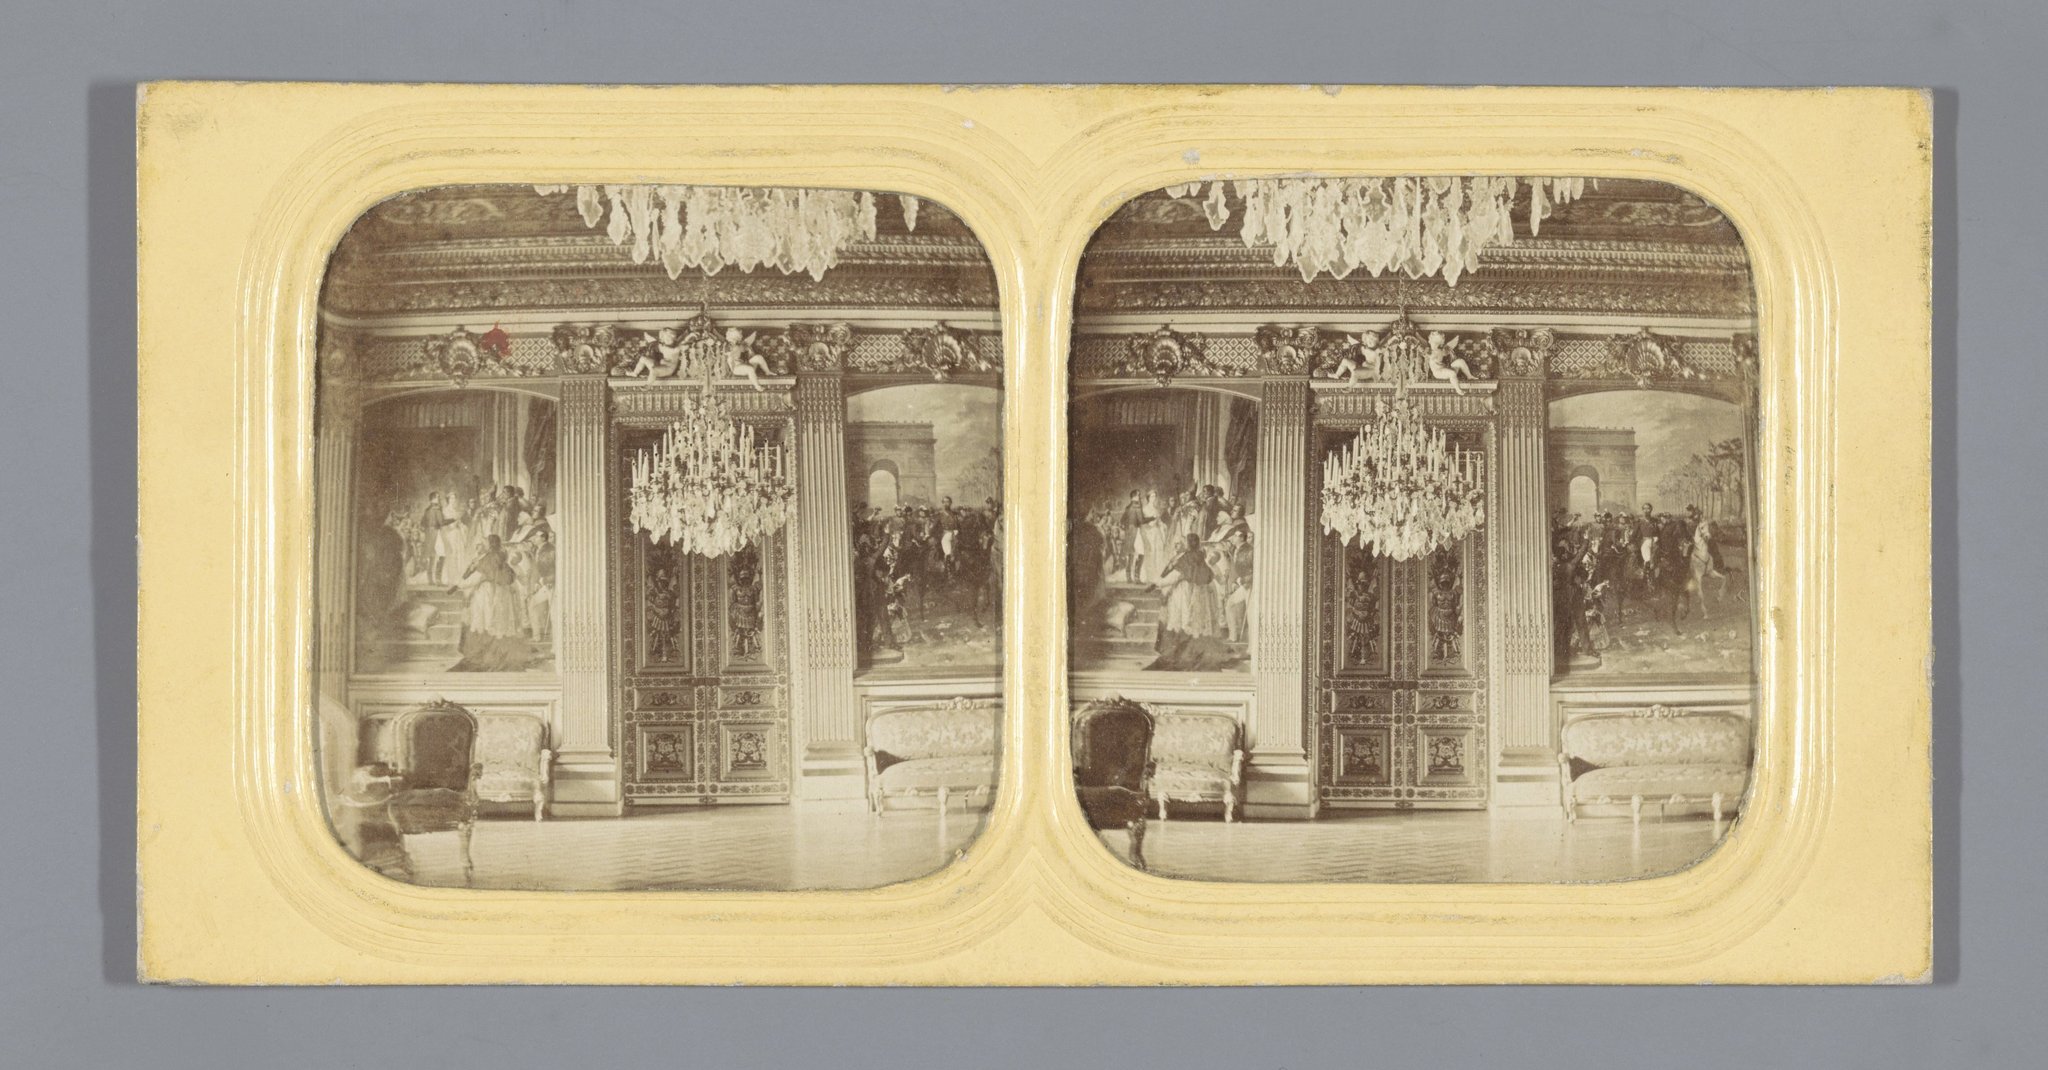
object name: tissue stereograph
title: Salle du Mariage du l'Empereur, Luxembourg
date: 1855-1860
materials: cardboard, paper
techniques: albumen print, hand coloring, perforating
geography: paris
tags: palace - aa - civic architecture: inside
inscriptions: inscription: ‘zelf gekocht in Parijs 27 Augustus 1860.’, retailer's mark: ‘222, Rue de Rivoli/ en face le Jardin des Tuileries./ Lecocq-Frêné/ Estampes Photographies/ Plans et Guides pour Voyageurs/ Vues pr Stéréoscopes.’